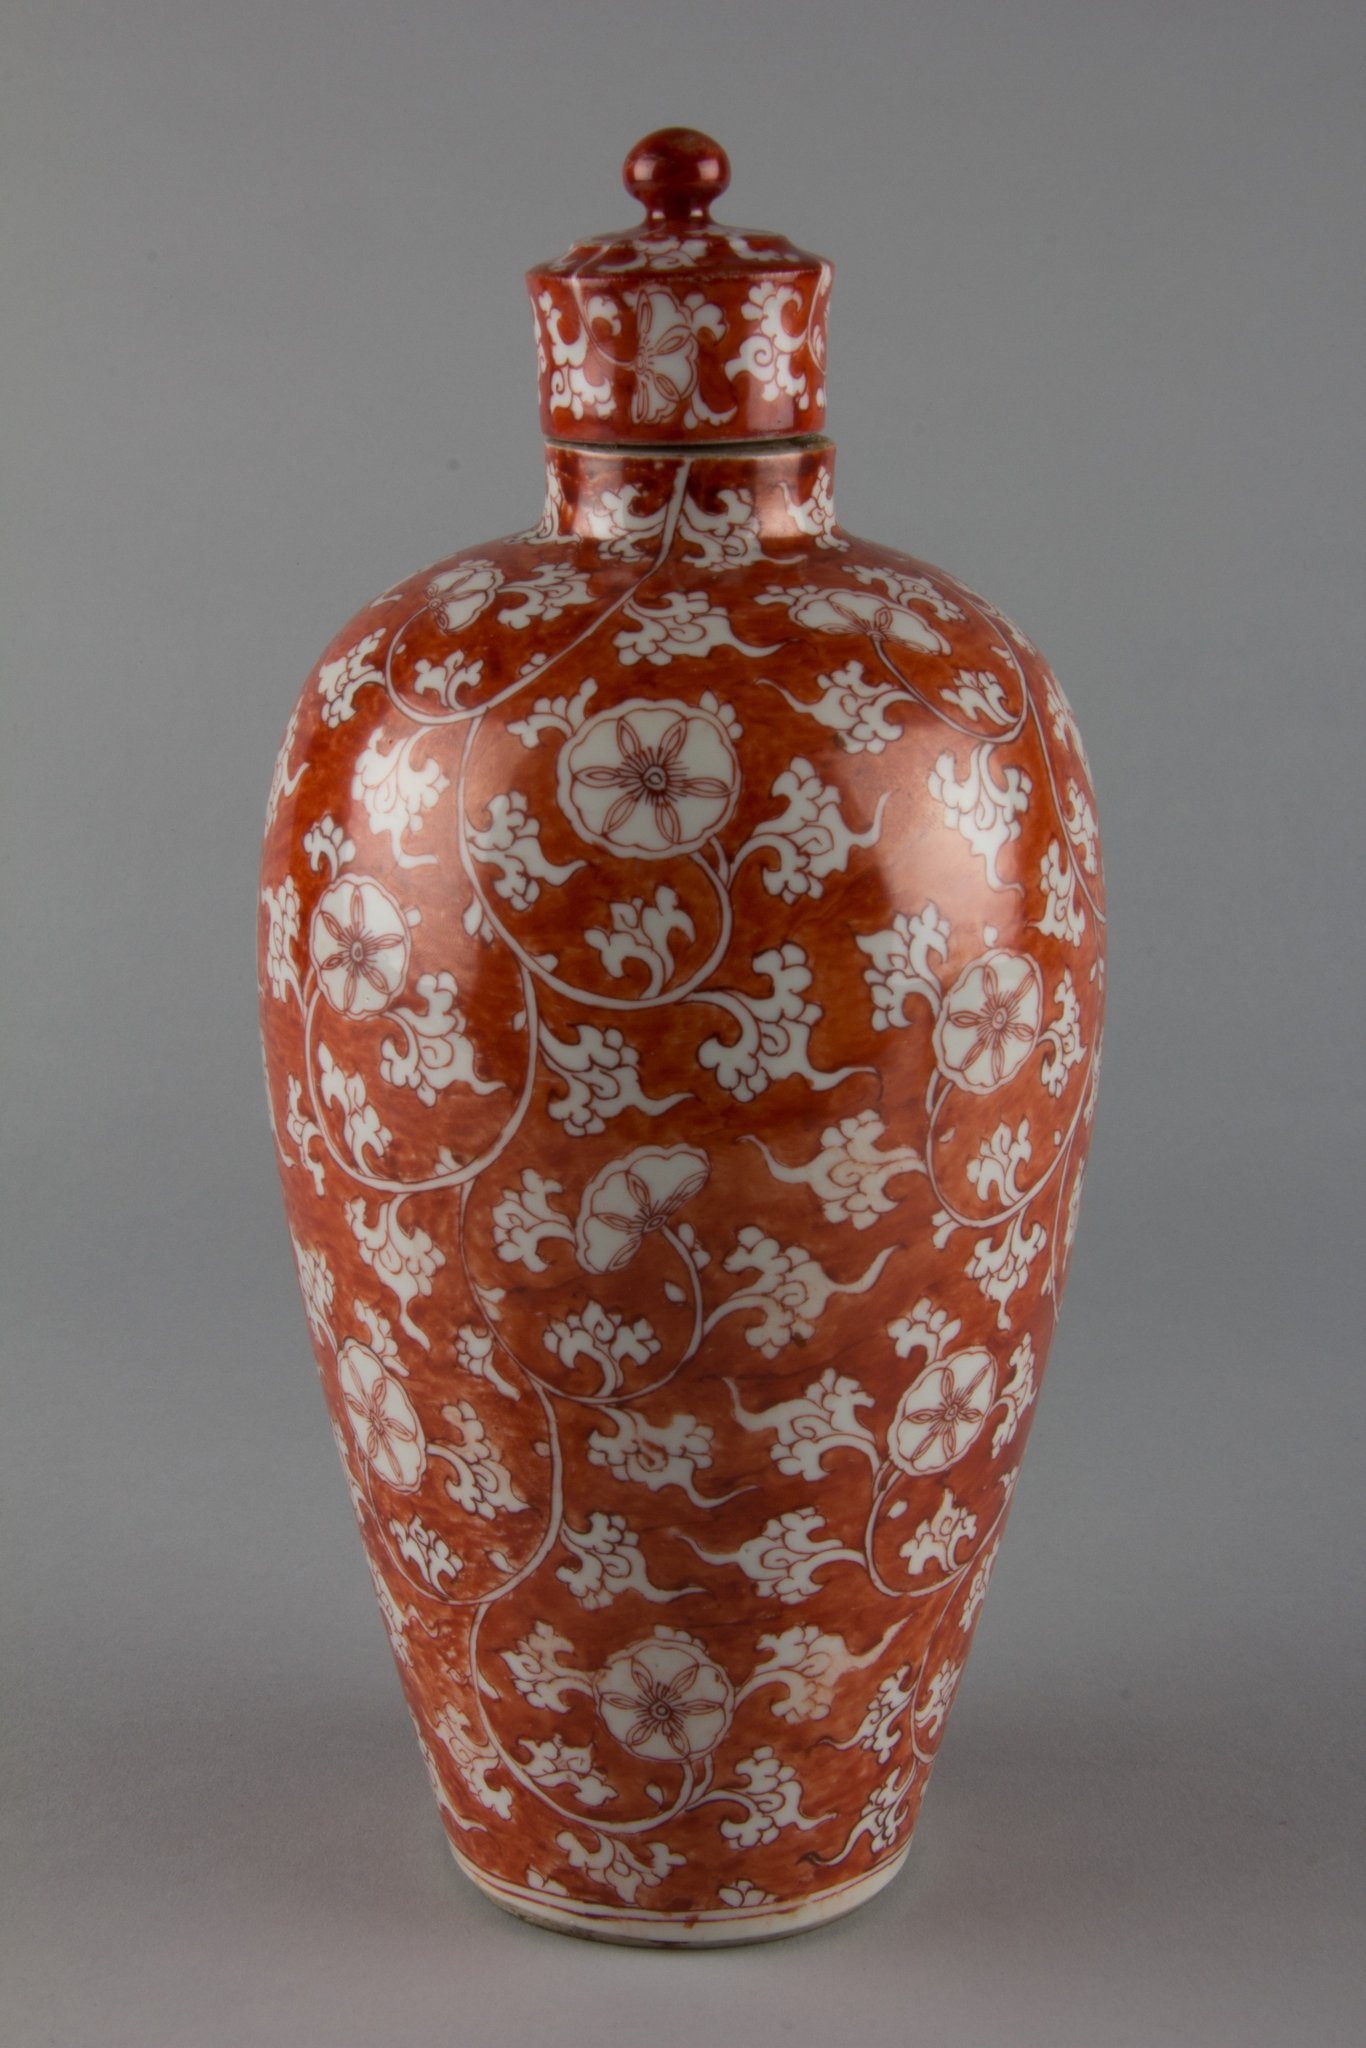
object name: covered bottle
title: Covered bottle with floral scrolls (one of a pair)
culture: chinese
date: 1701-1800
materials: enamel, porcelain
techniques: overglaze, painting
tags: flowers